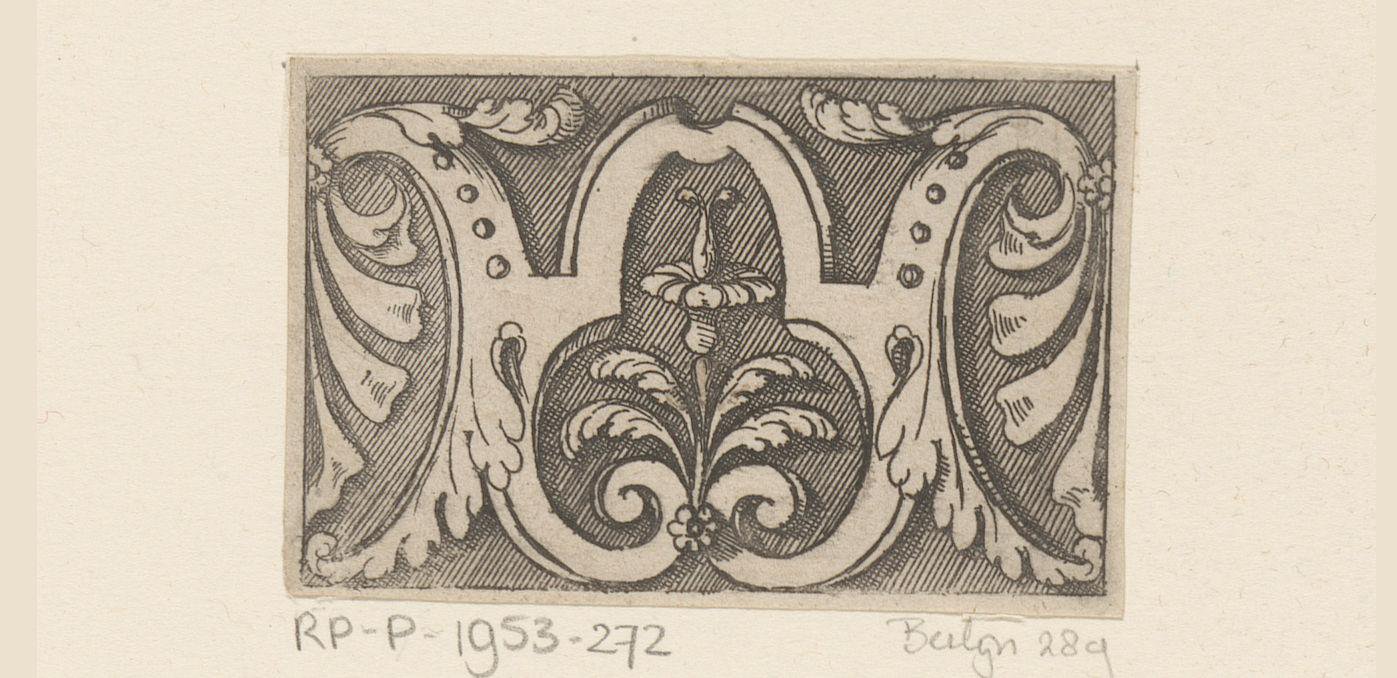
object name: print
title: Vlechtwerk met bloem in midden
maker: jacques androuet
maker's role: draughtsman, print maker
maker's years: 1515-1584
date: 1520-1584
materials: paper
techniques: etching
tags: interlace ~ ornament, flowers ~ ornament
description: Driepas met een bloem in het midden, geflankeerd door twee voluten die uitlopen in bladeren.